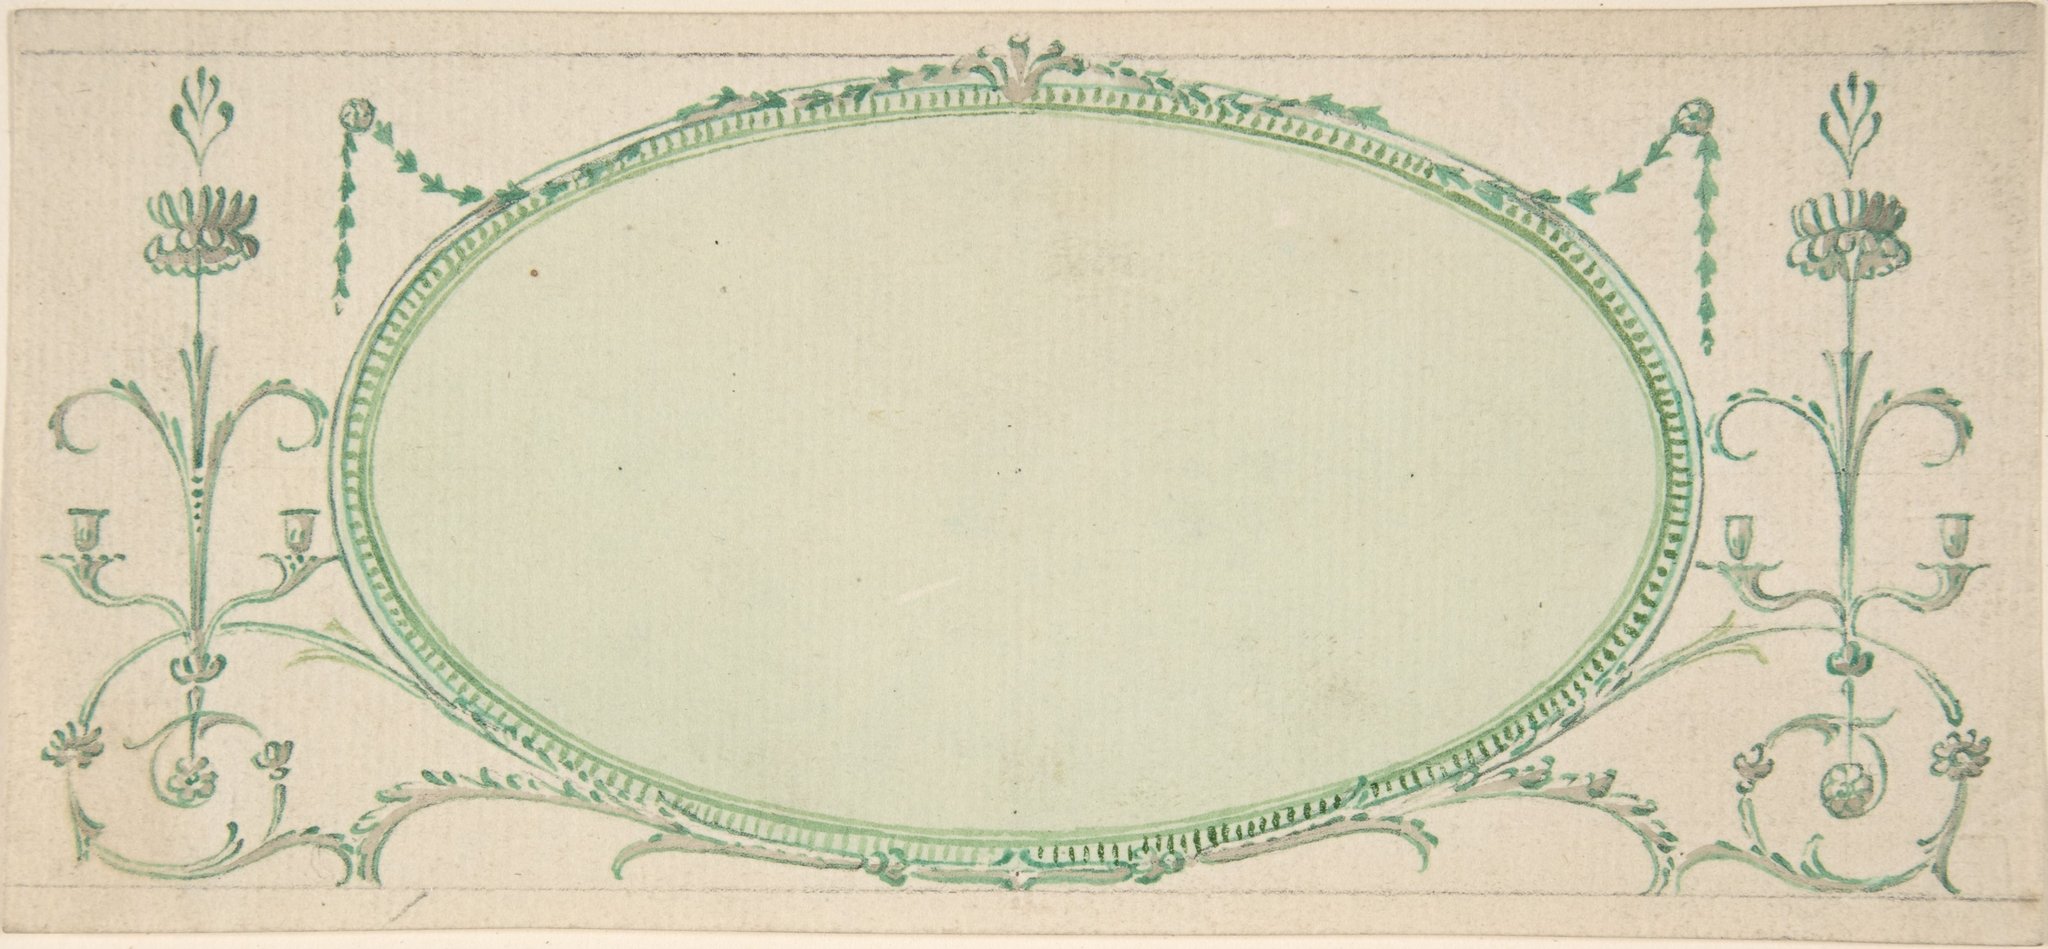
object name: drawing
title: Design for a Mirror in the Form of a Horizontal Oval, Elevation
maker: james wyatt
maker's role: artist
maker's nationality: british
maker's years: 1746-1813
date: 1734-1833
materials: ink, watercolor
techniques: brush, pen, wash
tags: mirrors